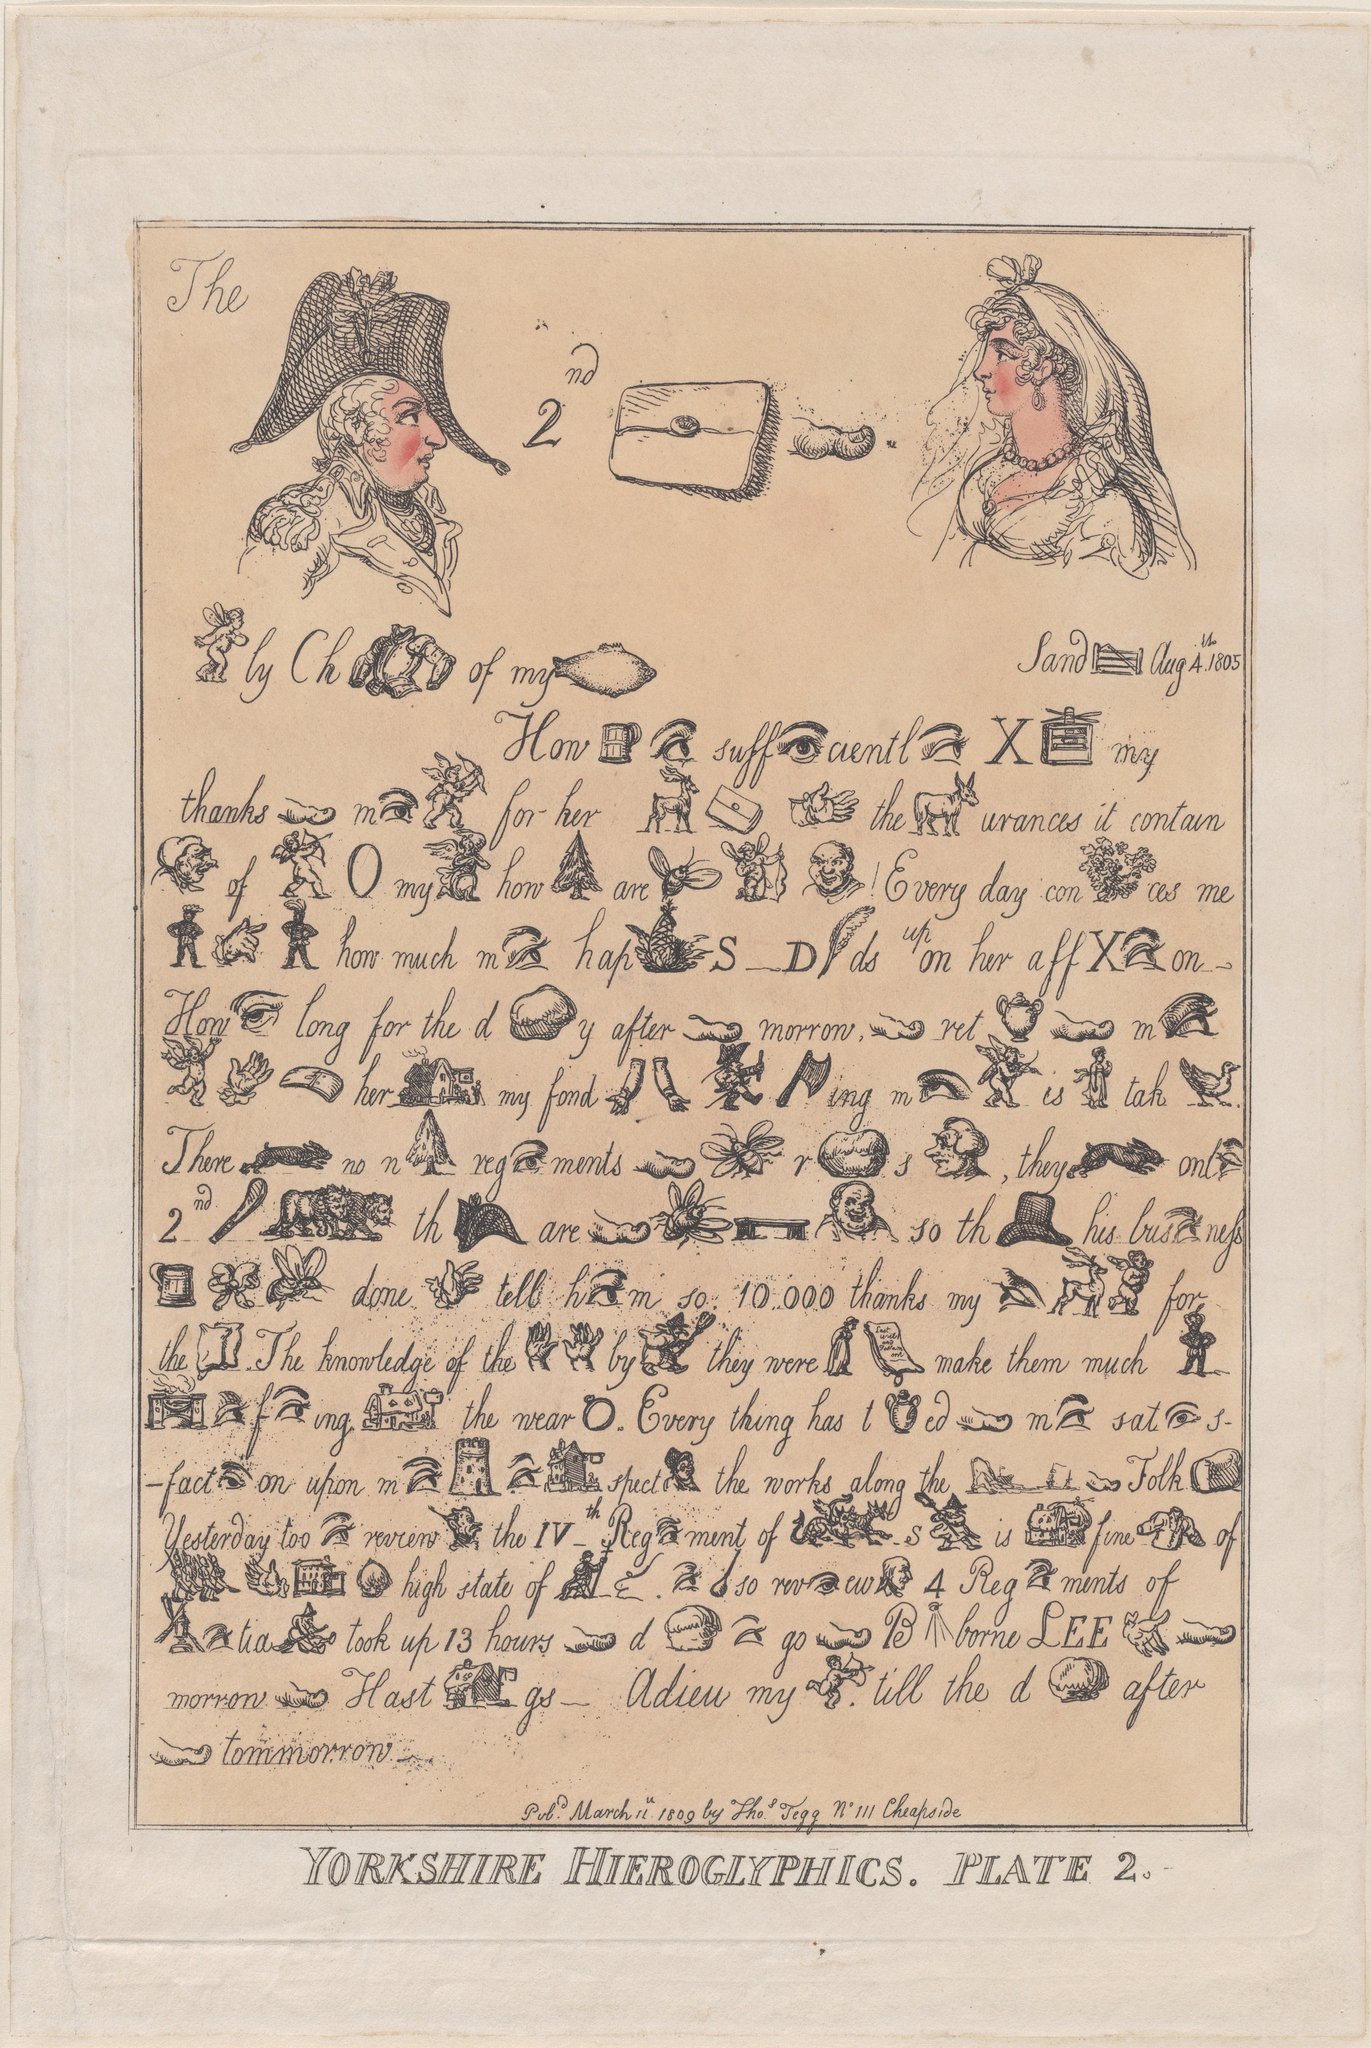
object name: print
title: Yorkshire Hieroglyphics, Plate 2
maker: thomas rowlandson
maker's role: artist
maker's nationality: british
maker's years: 1757-1827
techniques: etching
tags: satire,hieroglyphs,politics